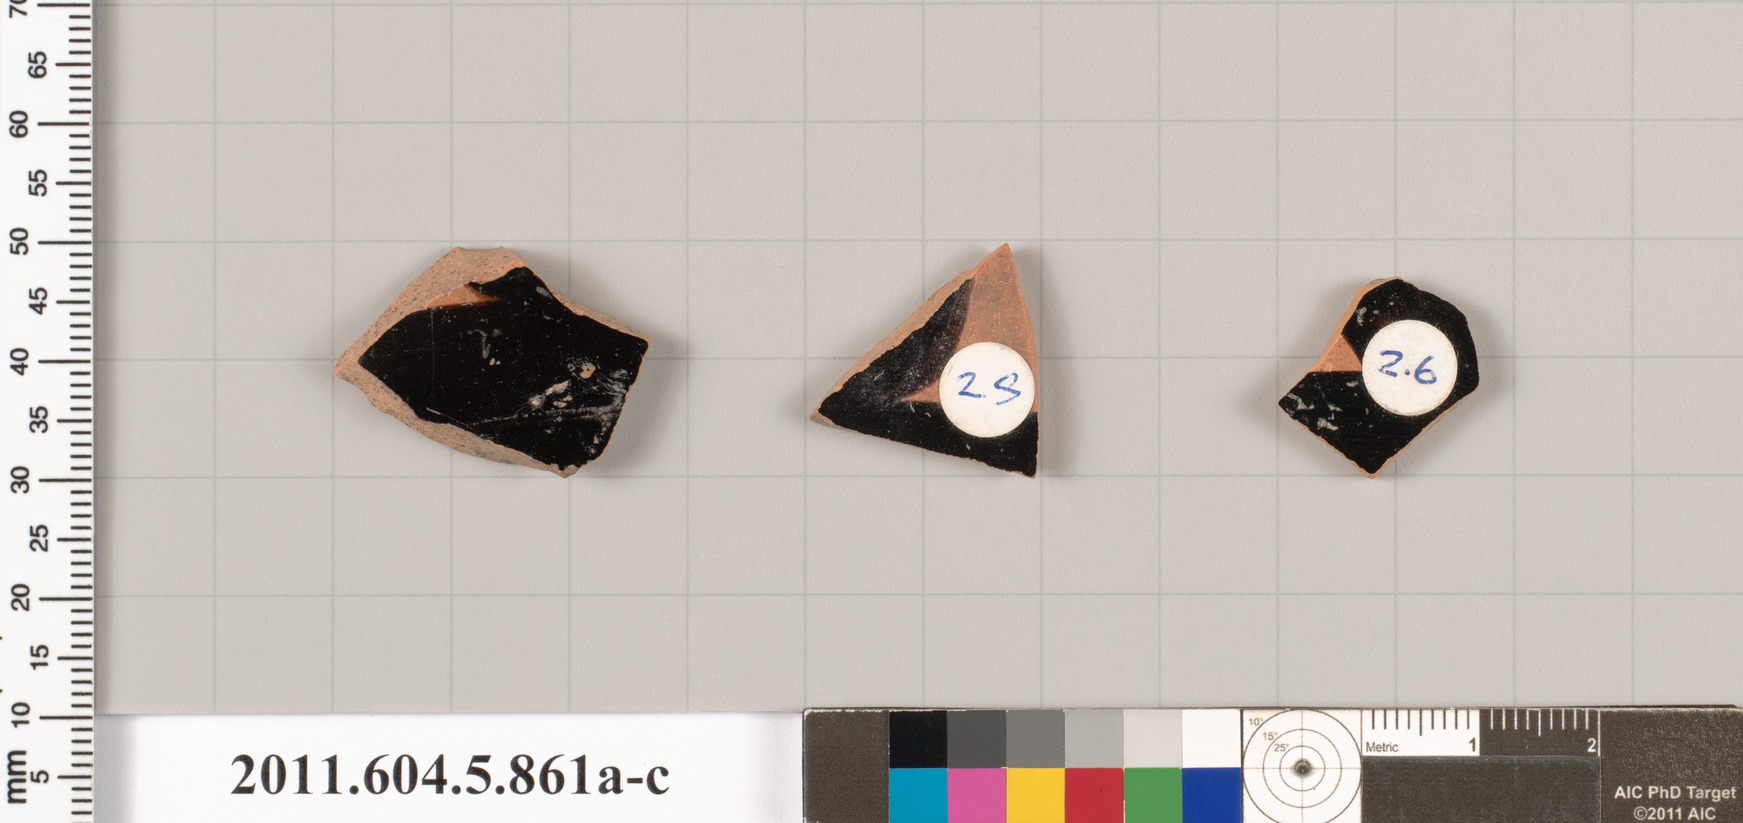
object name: kylix fragment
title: Terracotta fragments of kylikes (drinking cups)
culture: greek, attic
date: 600-401 BCE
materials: terracotta